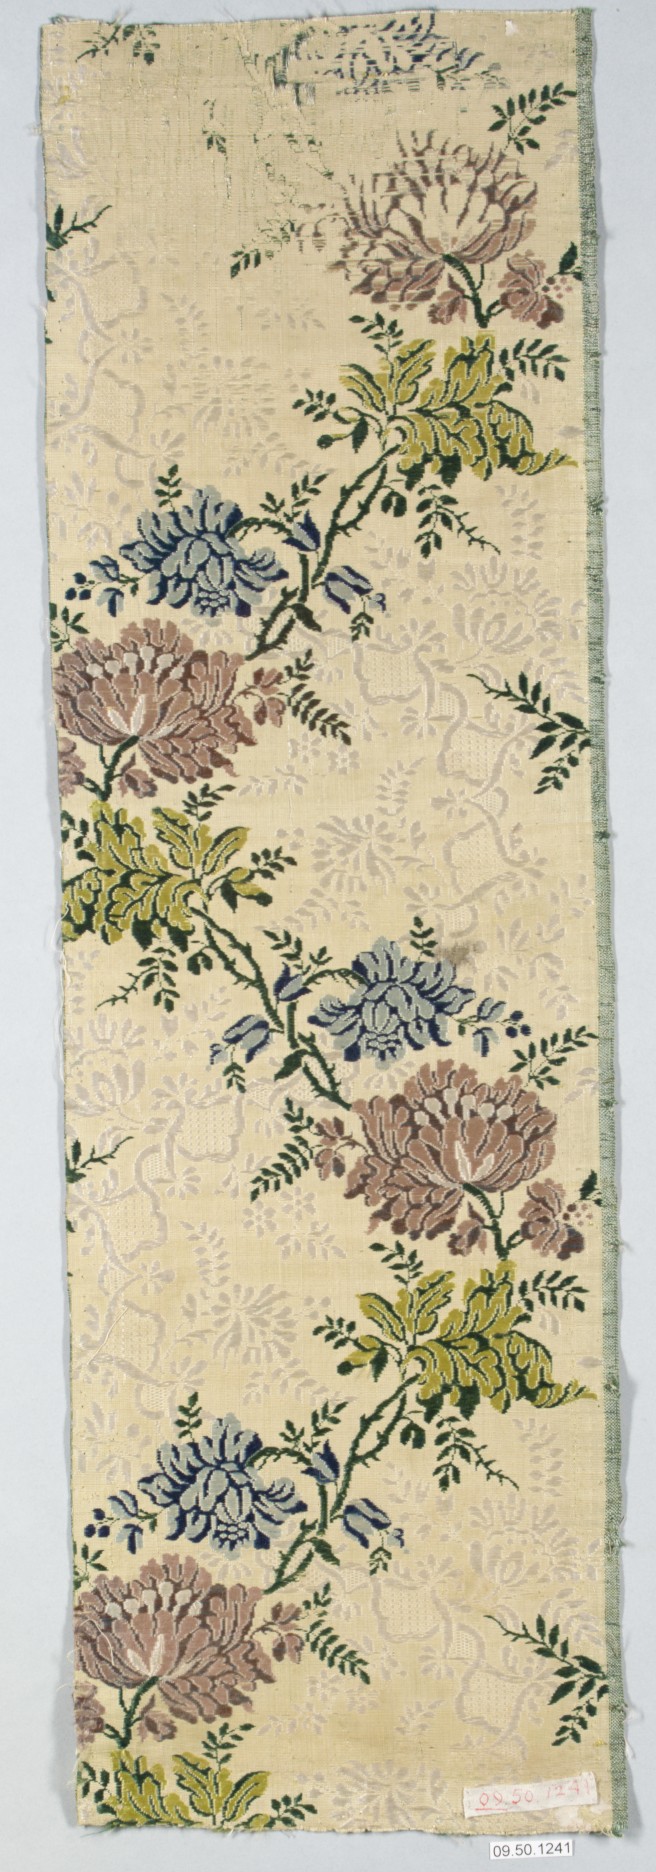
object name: piece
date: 1750-1765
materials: silk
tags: flowers,leaves